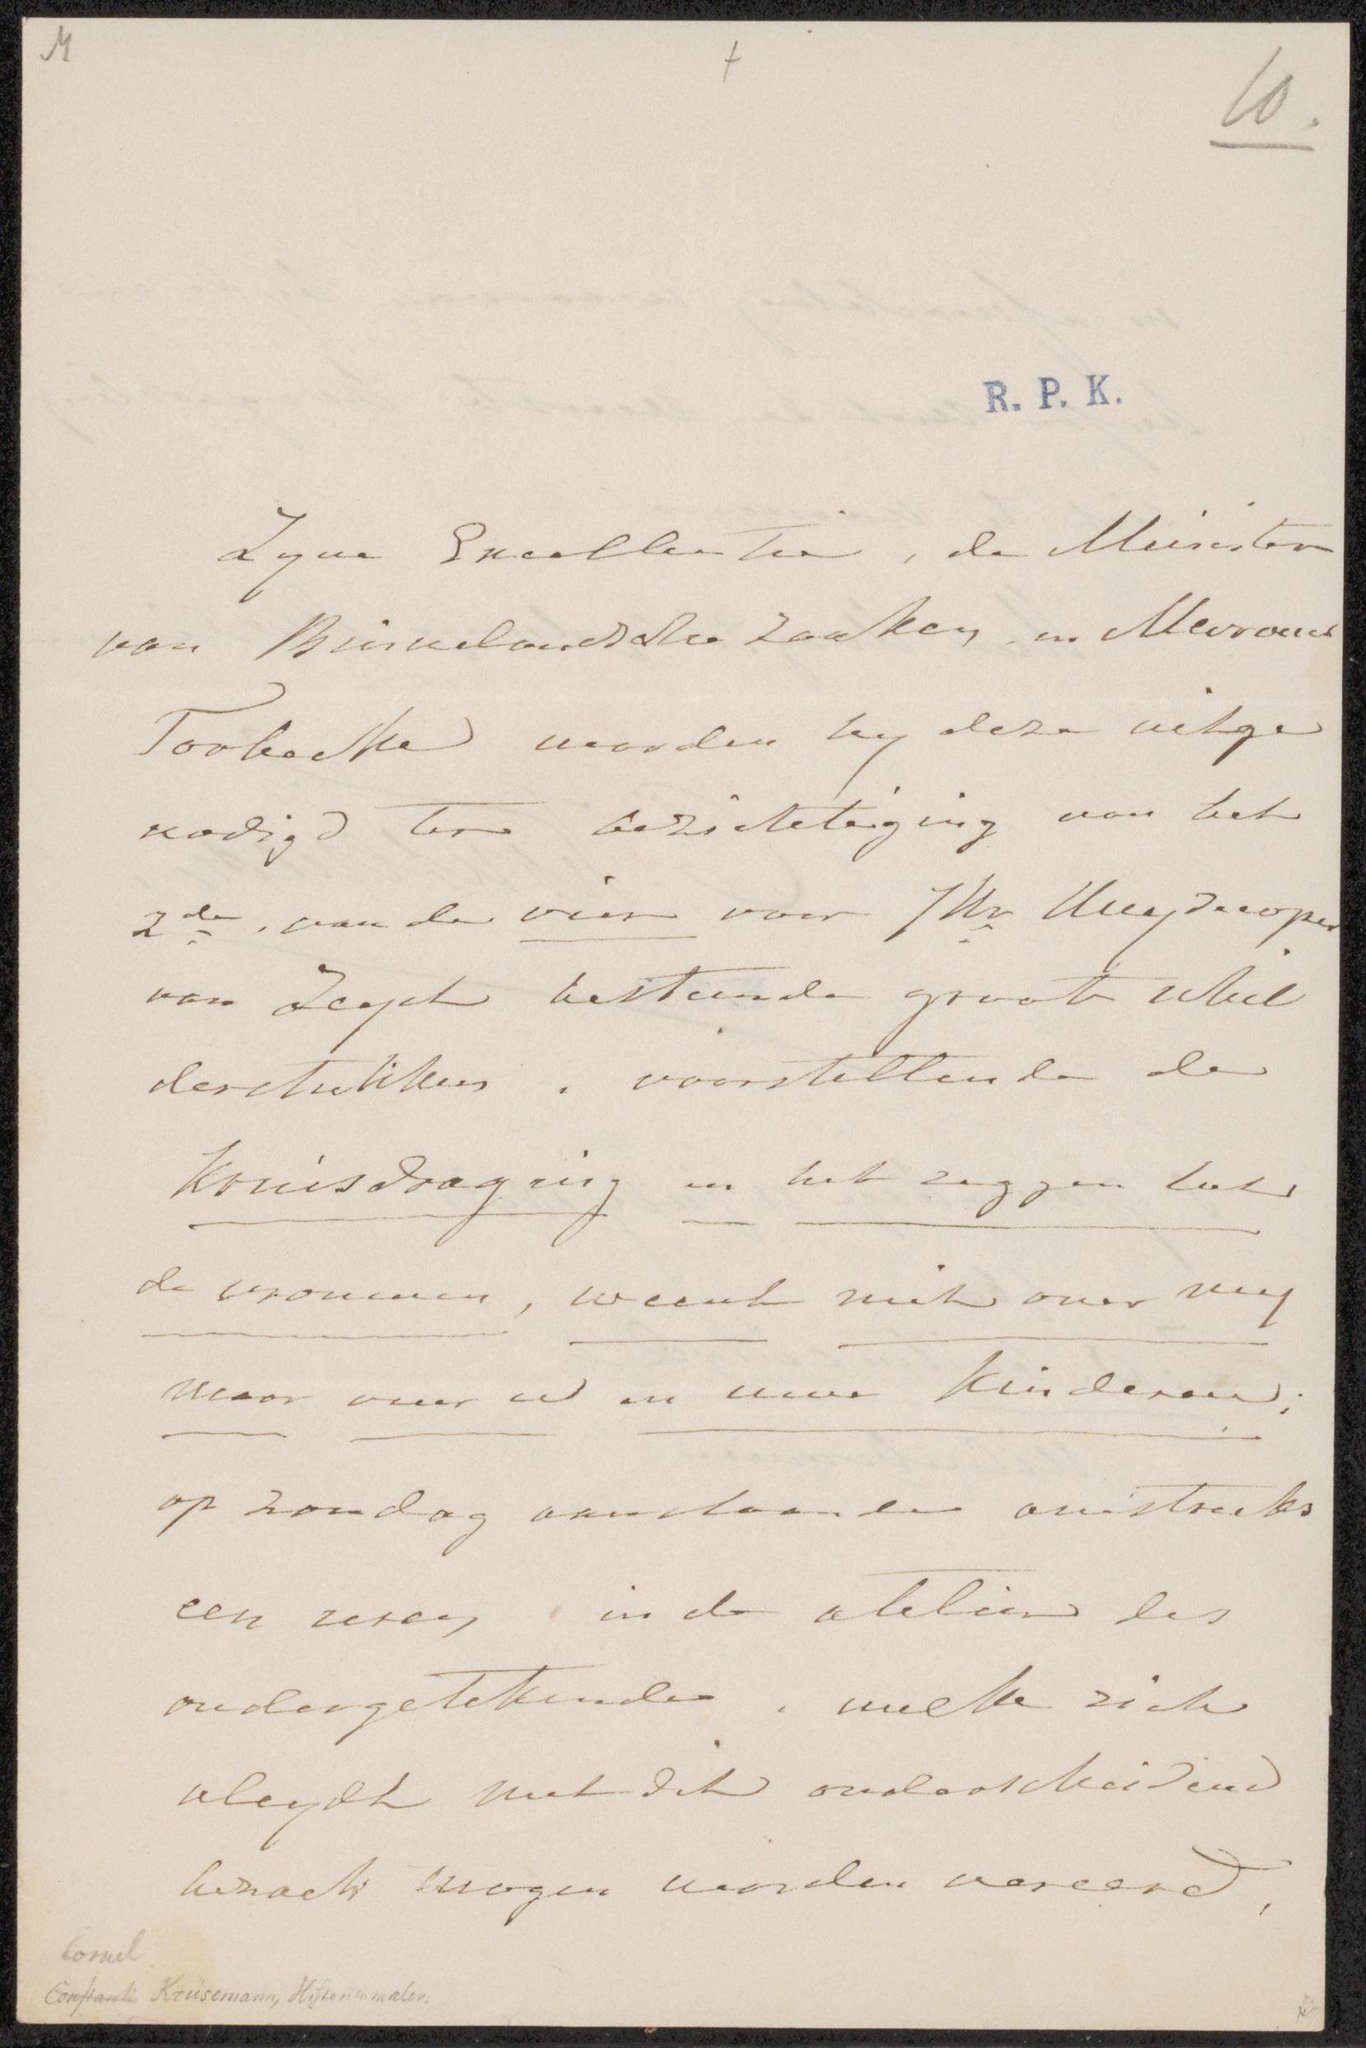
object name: letter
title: Brief aan Johan Rudolf Thorbecke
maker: cornelis kruseman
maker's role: draughtsman, painter, print maker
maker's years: 1797-1857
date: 1841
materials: ink, paper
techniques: pen, writing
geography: the hague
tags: zeist, politician, the hague, johan rudolf thorbecke, painting (including book-illumination, miniature-painting), workshop, studio of the artist (in general)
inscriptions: collector's mark: Lugt 2233